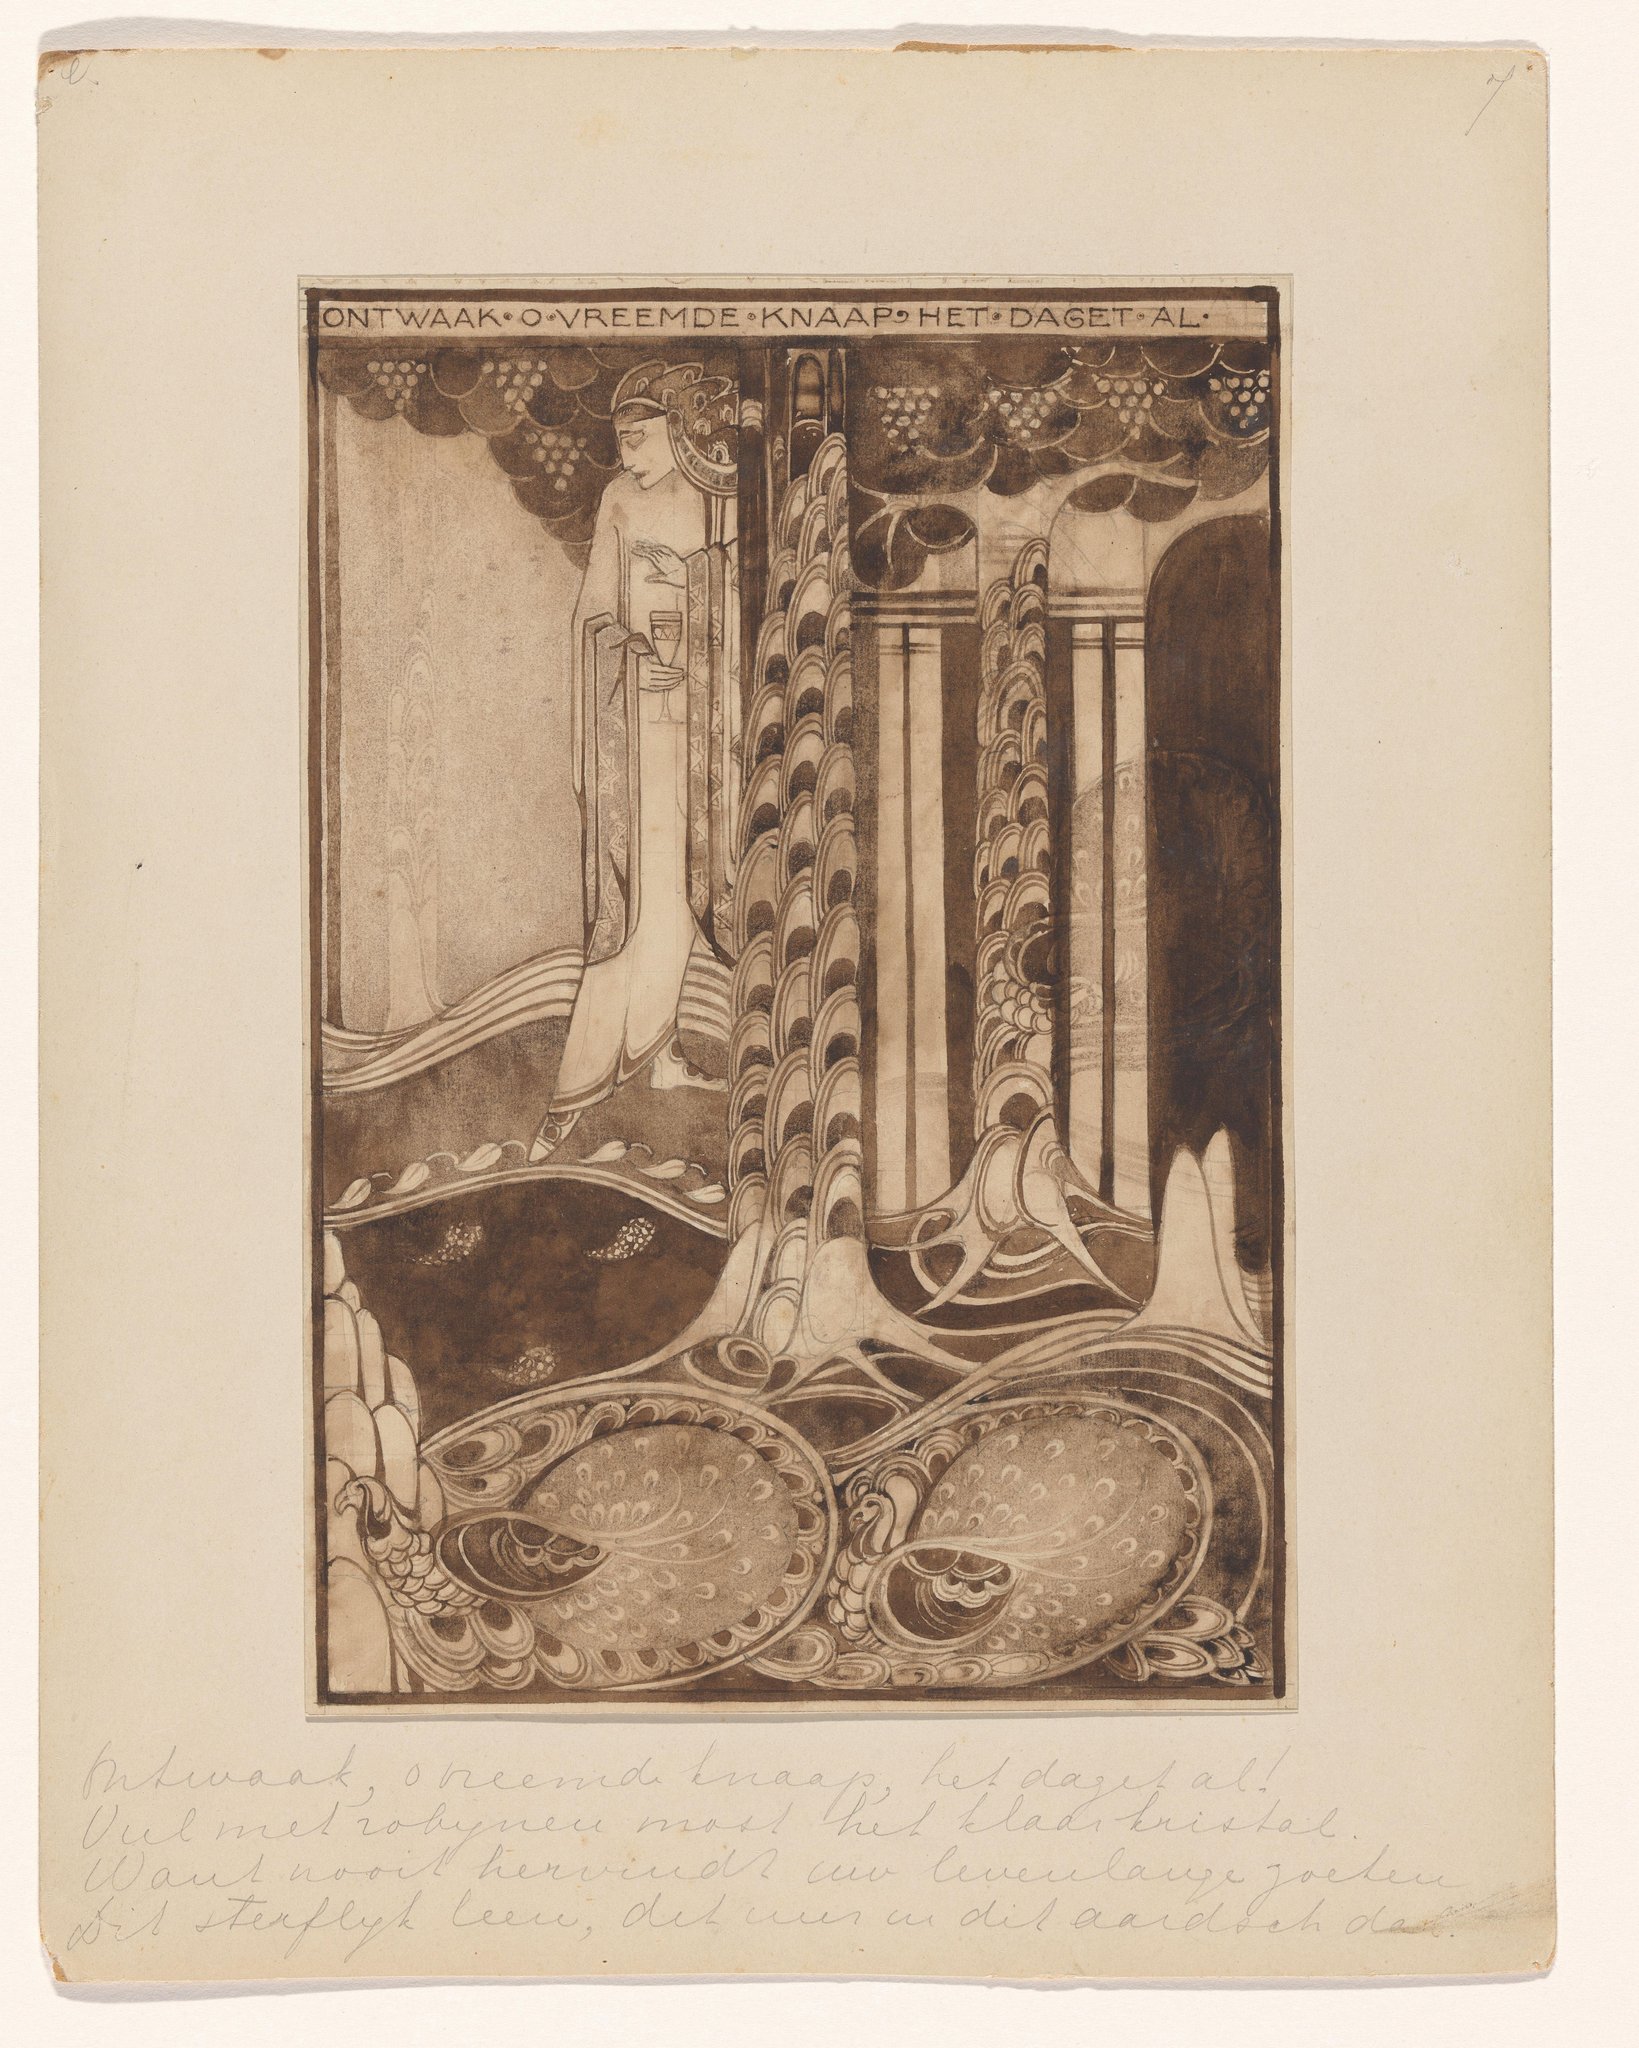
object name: drawing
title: Ontwaak o vreemde knaap, het daget al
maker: willem arondéus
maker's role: draughtsman, print maker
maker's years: 1894-1943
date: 1914-1920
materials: cardboard, ink, paper, pencil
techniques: brush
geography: netherlands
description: Tekening naar de Rubaiyat van Omar Khayyam.